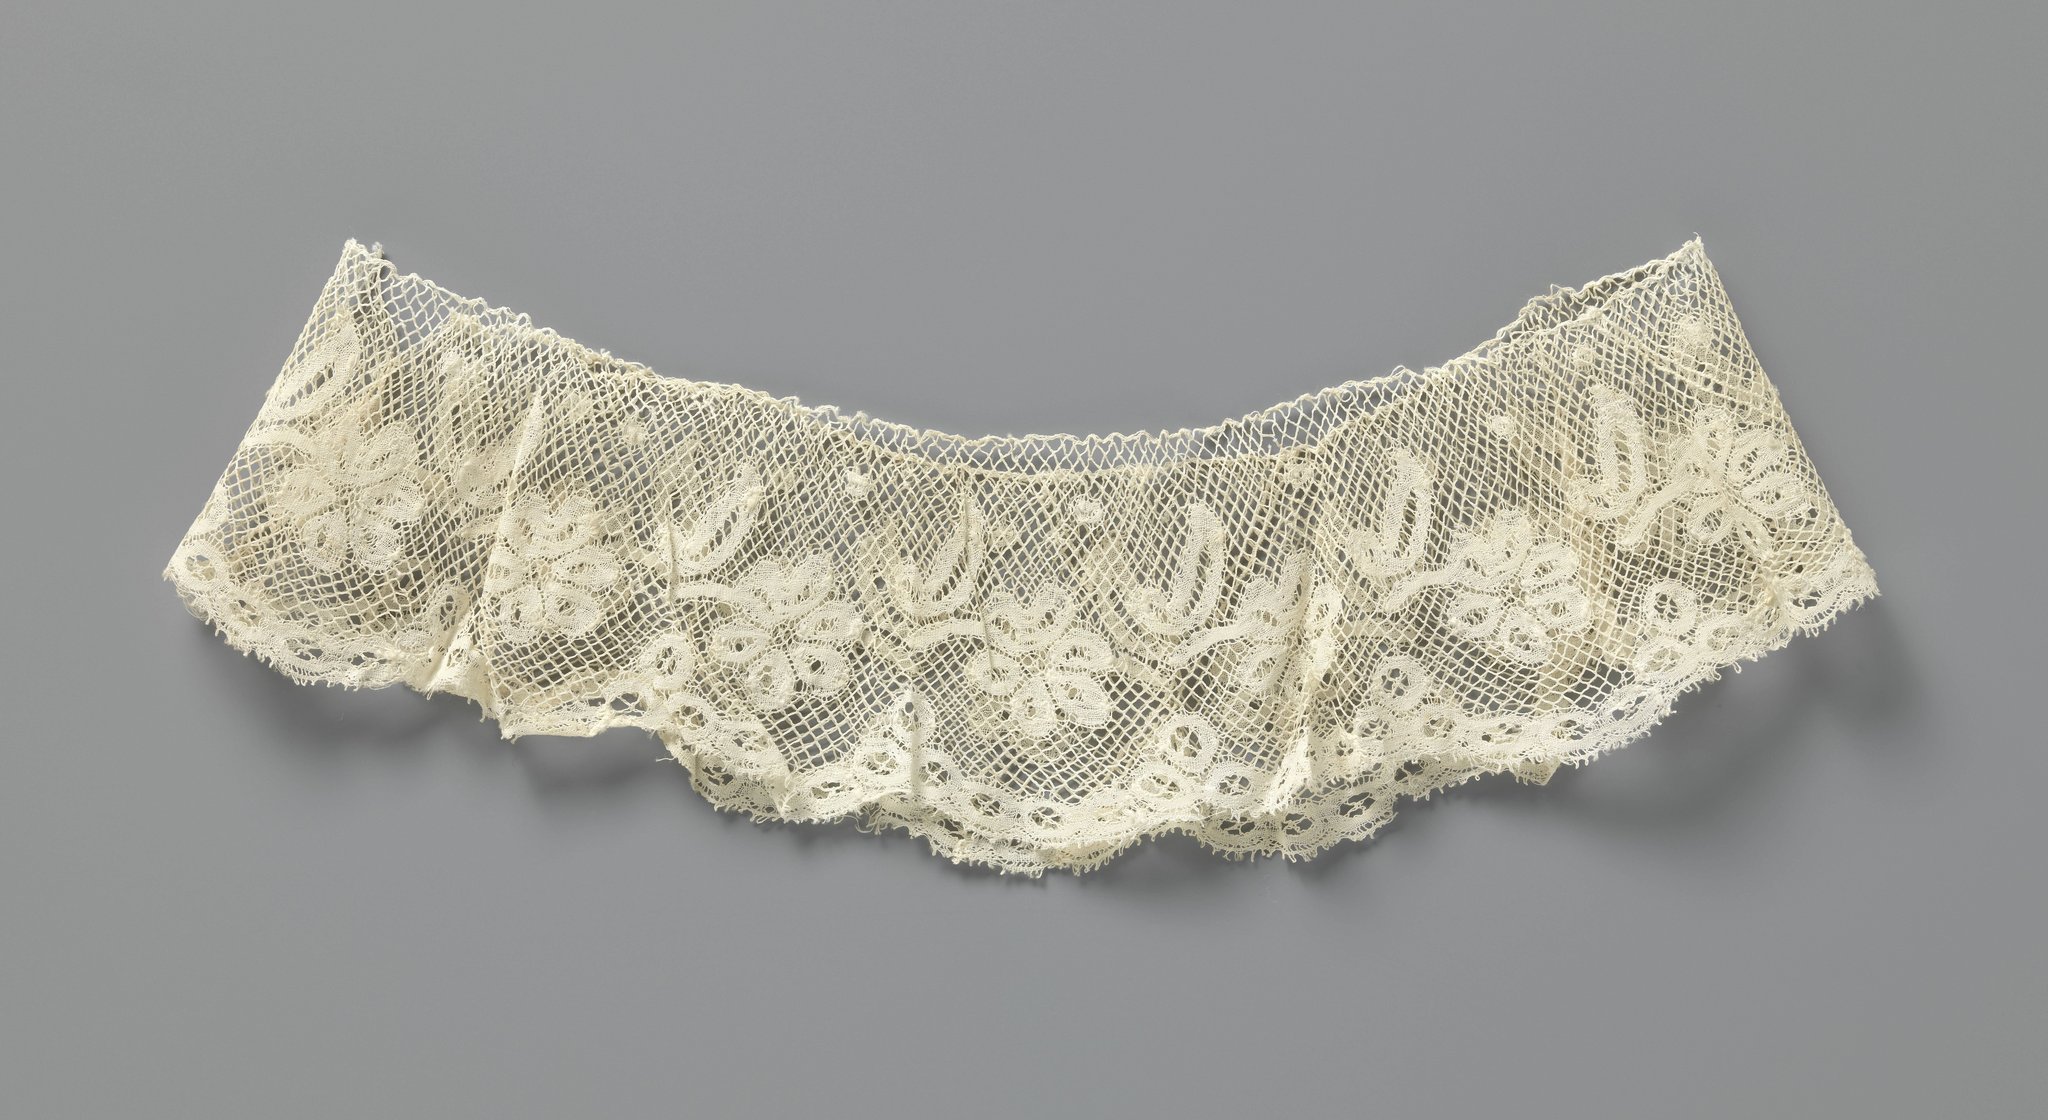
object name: cuff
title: Manchet van kloskant met margrietjes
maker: Anonymous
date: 1900-1924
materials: linen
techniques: lace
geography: sluis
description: De strook met margrietjes bestond volgens de catalogus 'Kant uit Koninklijk bezit' uit drie losse delen en had één inventarisnummer: J-272. Mogelijk voor een tentoonstelling zijn hier echter meerdere delen van gemaakt of zijn er juist delen aan elkaar genaaid of vermaakt tot een kraag en manchetten. Aan de verschillende delen zijn subnummers toegekend. De totale lengte van deze stroken bij elkaar is om onduidelijke redenen langer dan de in de catalogus aangegeven totaallengte van J-272.